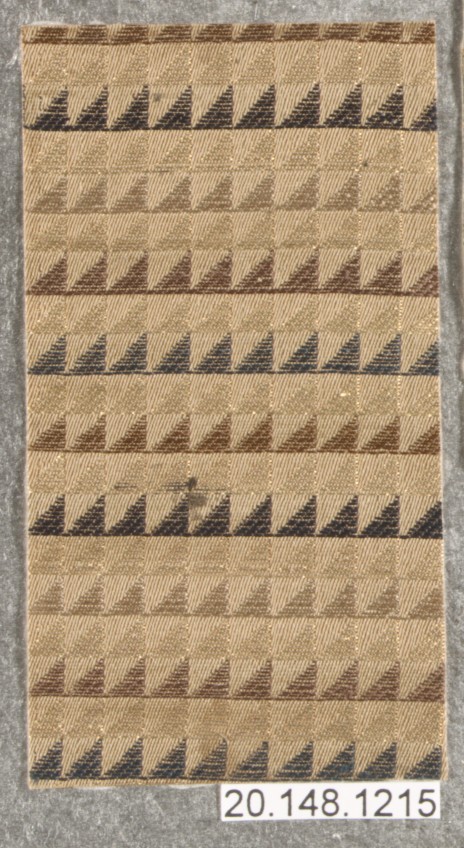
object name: piece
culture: japanese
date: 1801-1900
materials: silk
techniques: compound weave